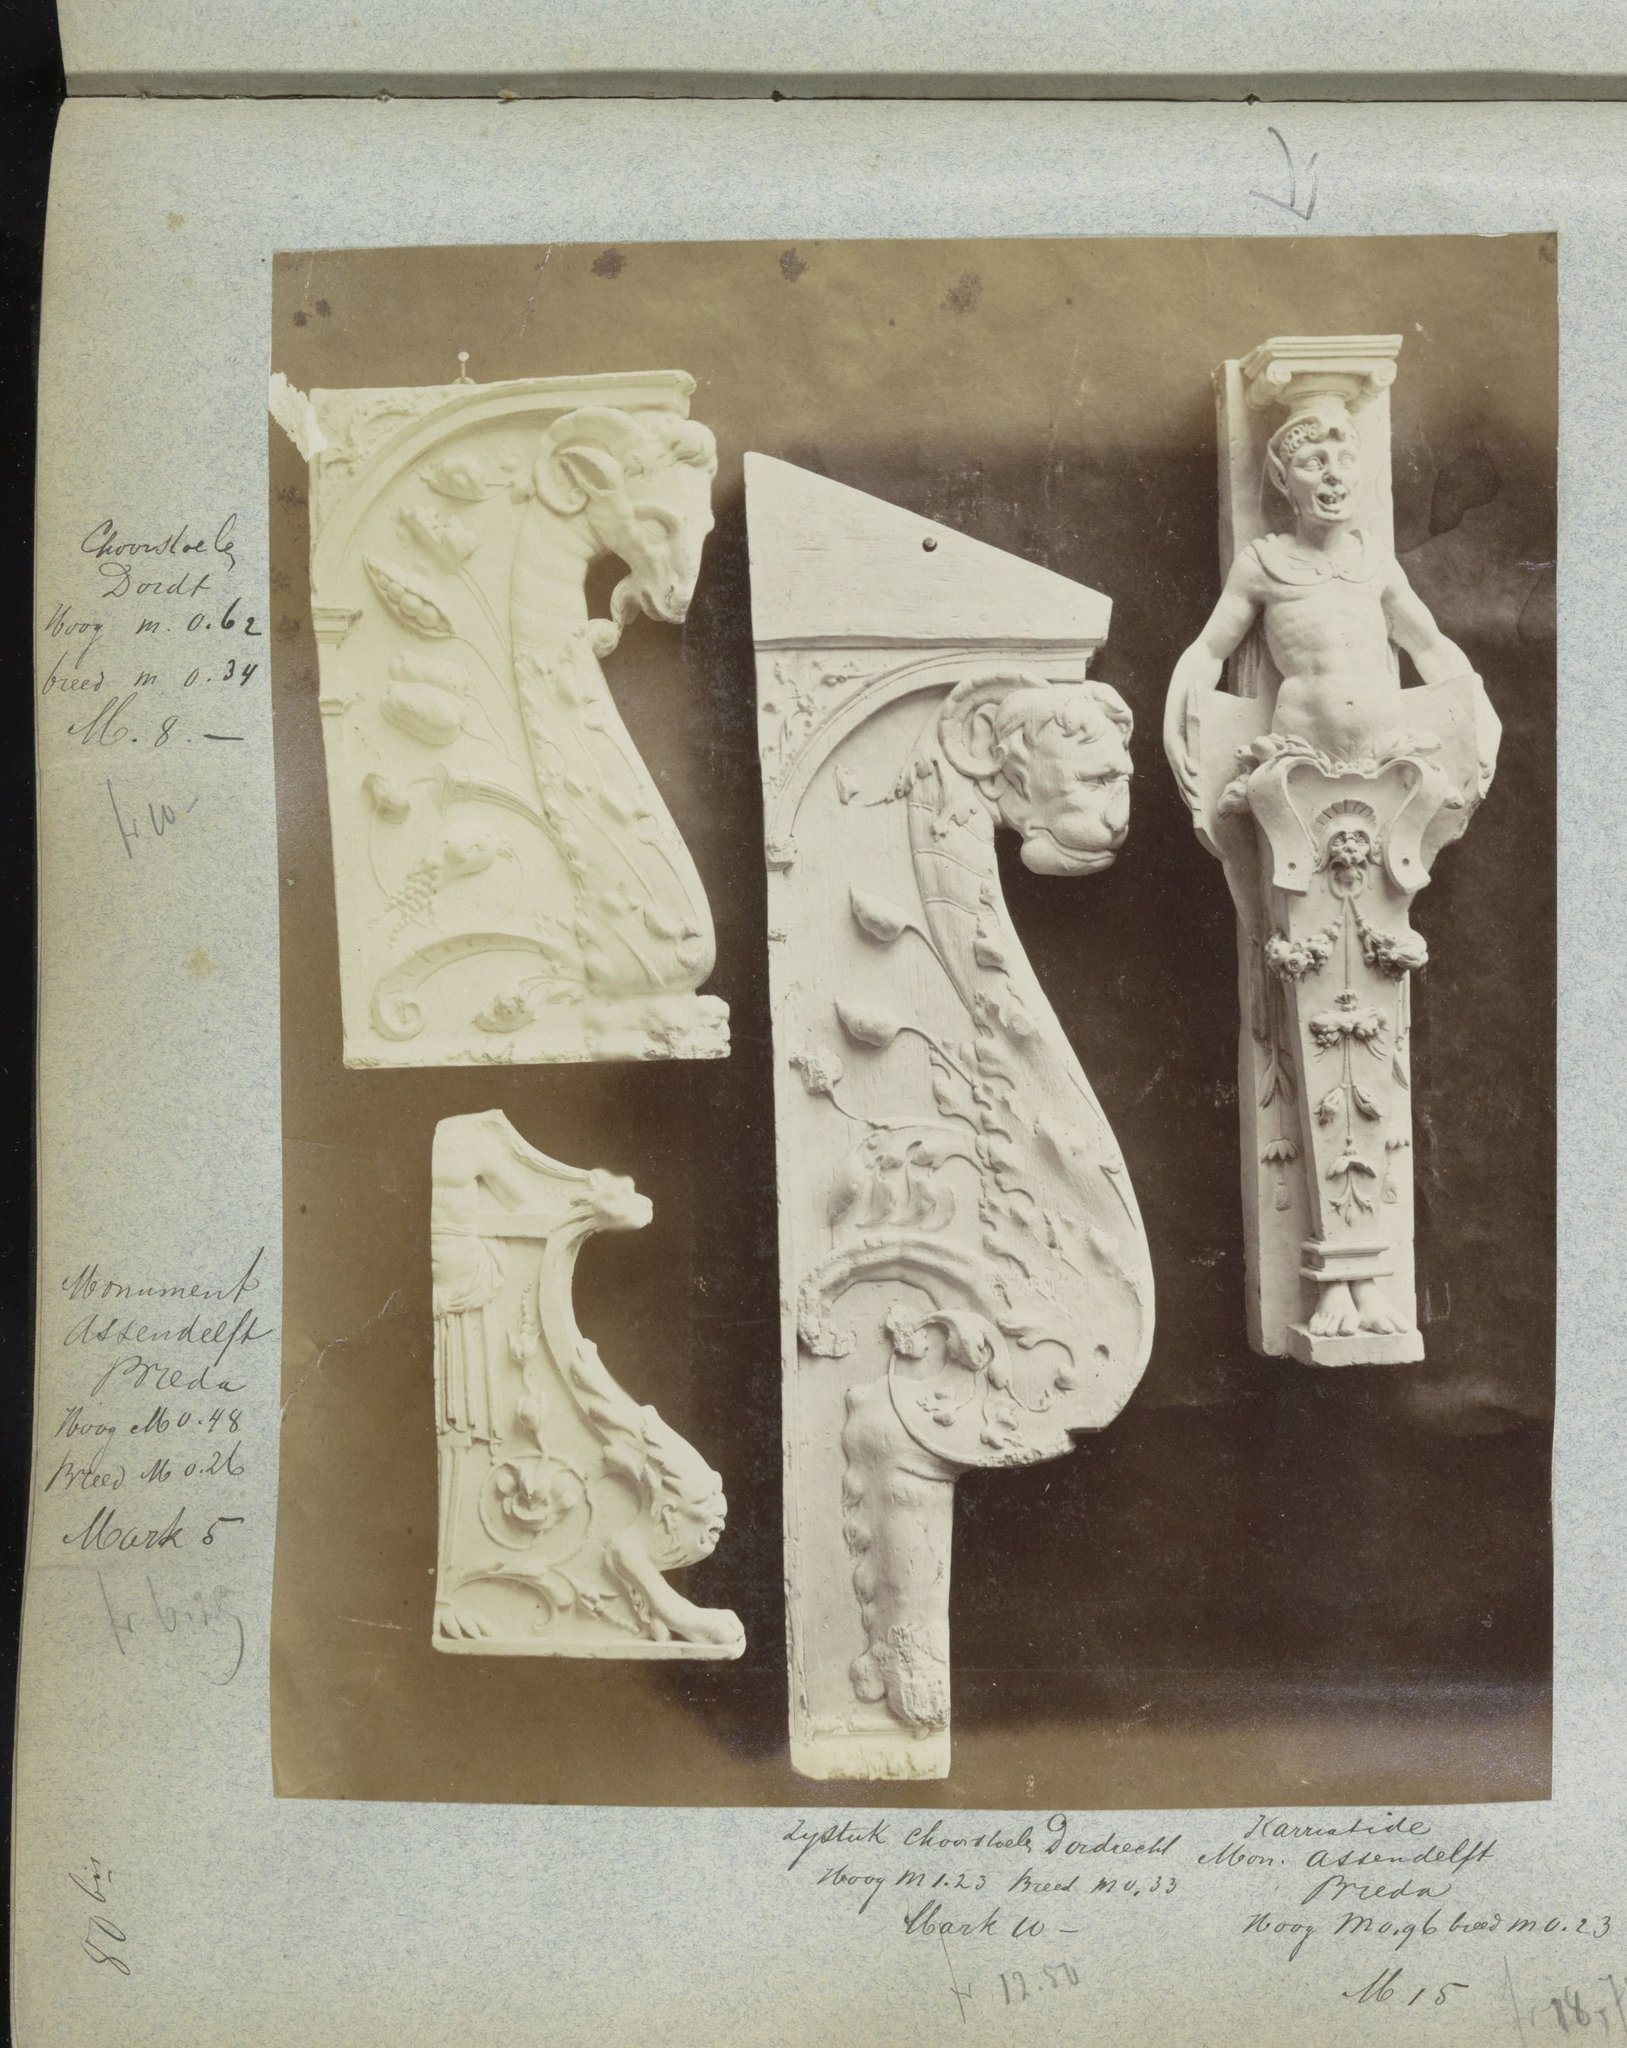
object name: album leaf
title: Gipsen afgietsels van sculpturen van een koorgestoelte, vermoedelijk van de Grote Kerk te Dordrecht, en van een Monument van Assendelt te Breda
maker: Anonymous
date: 1875-1900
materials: paper, photographic support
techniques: albumen print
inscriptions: annotation, annotation: ‘Kariatide / Mon. Assendelft / Breda / hoog M 0.96 Breed 0.23’, annotation: ‘koorstoelen / Dord / hoog M 0.62 / breed M 0.34’, annotation: ‘Monument / Assendelft / Breda / hoog 0.48 / Breed 0.26’, annotation: ‘Zijstuk koorstoelen Dordrecht / hoog M 1.23 breed M 0.33’